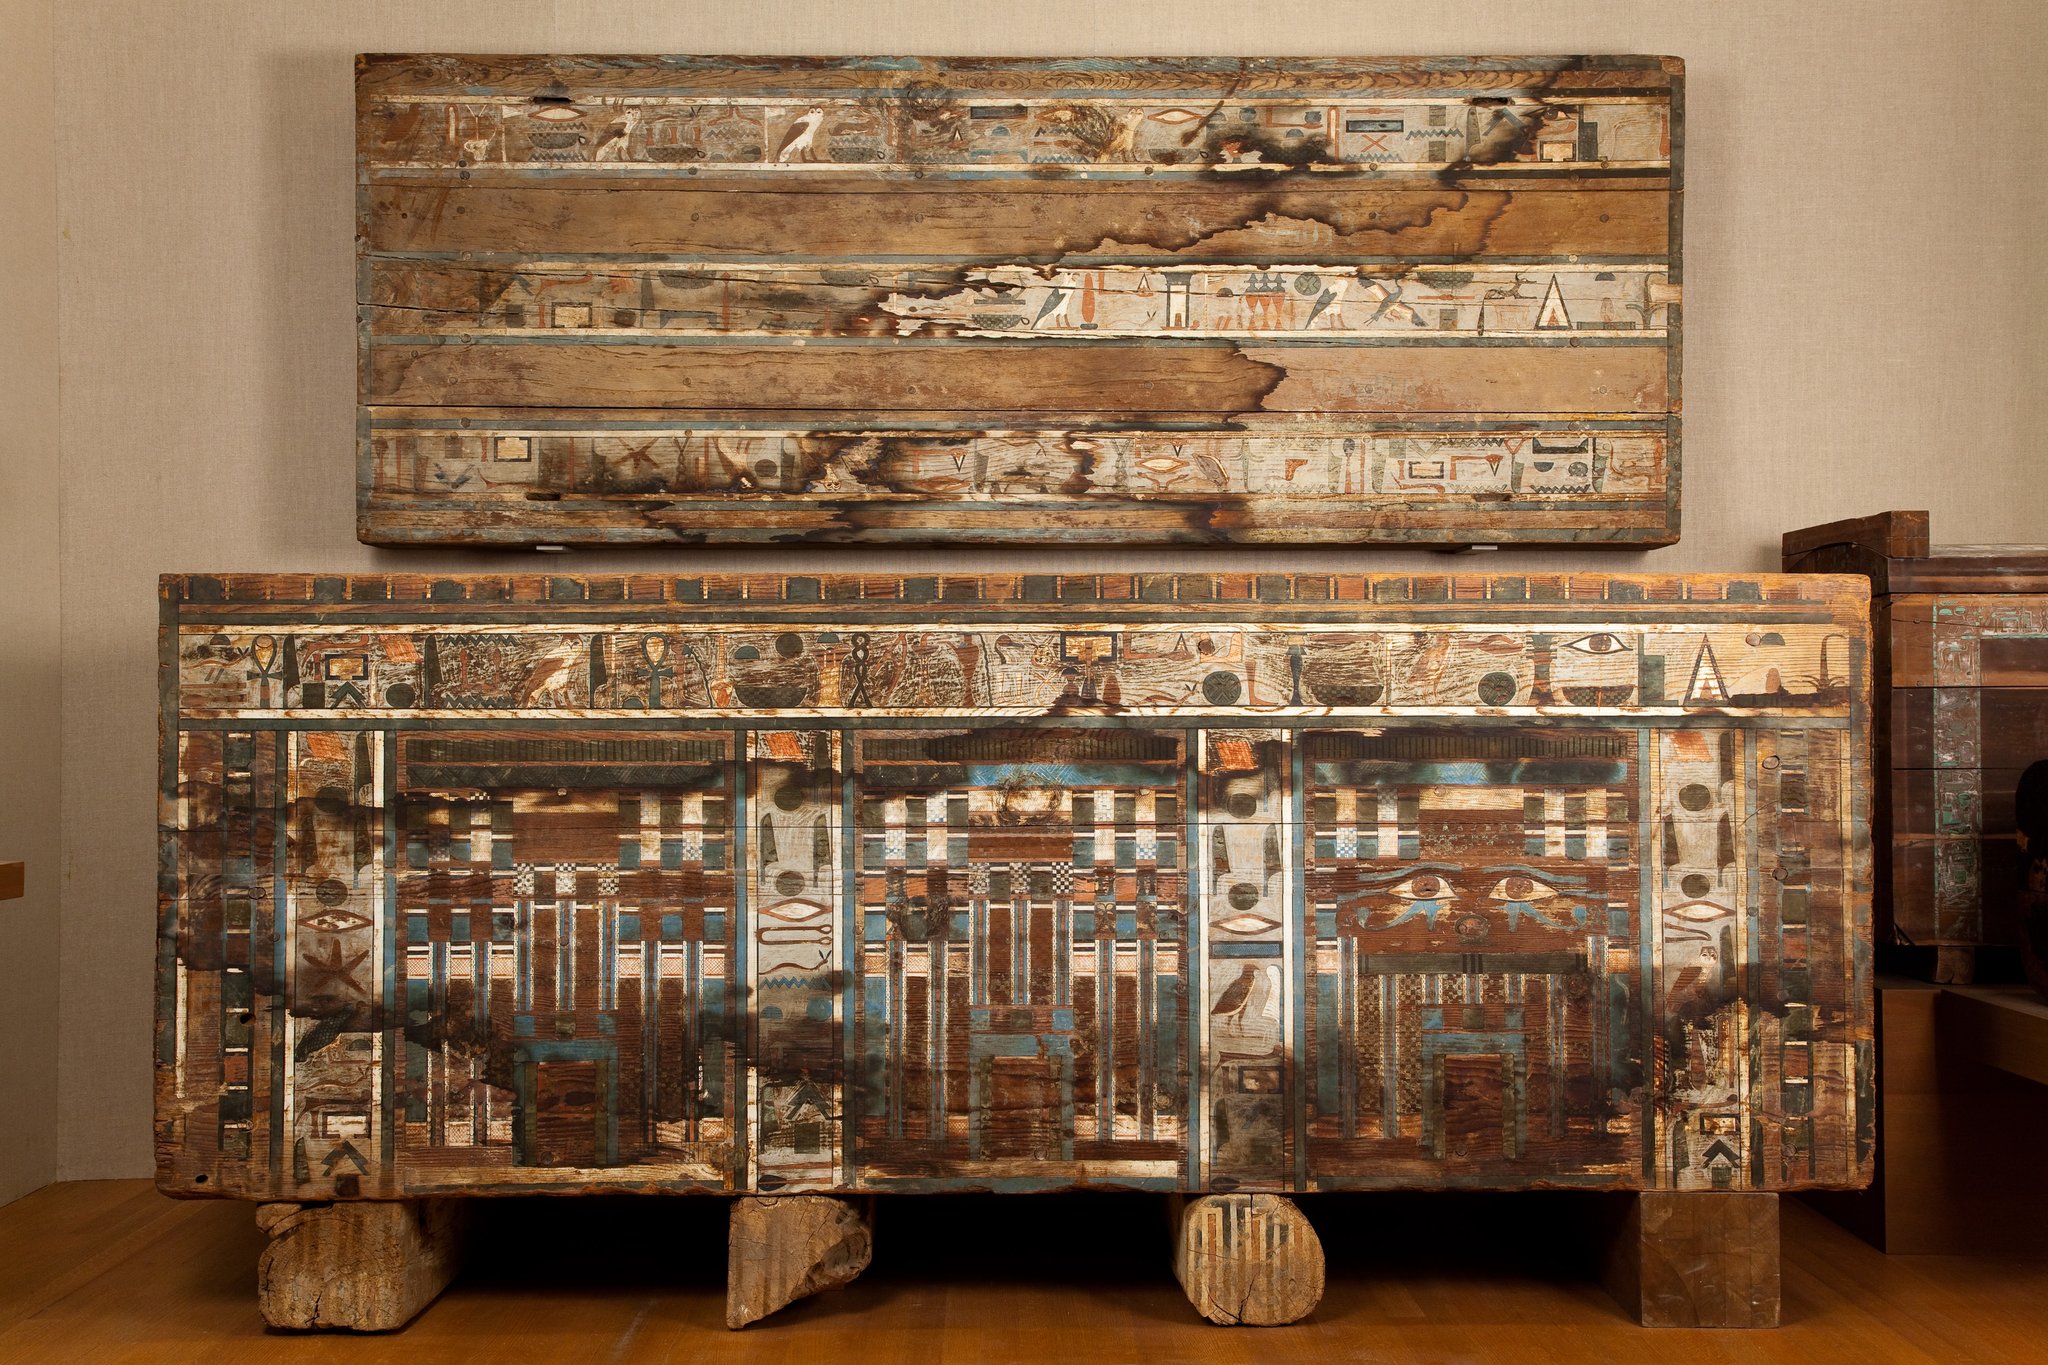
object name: coffin, hapiankhtifi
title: Outer coffin of Hapiankhtifi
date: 1981-1802 BCE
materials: brass, iron, paint, wood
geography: egypt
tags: hieroglyphs,coffins